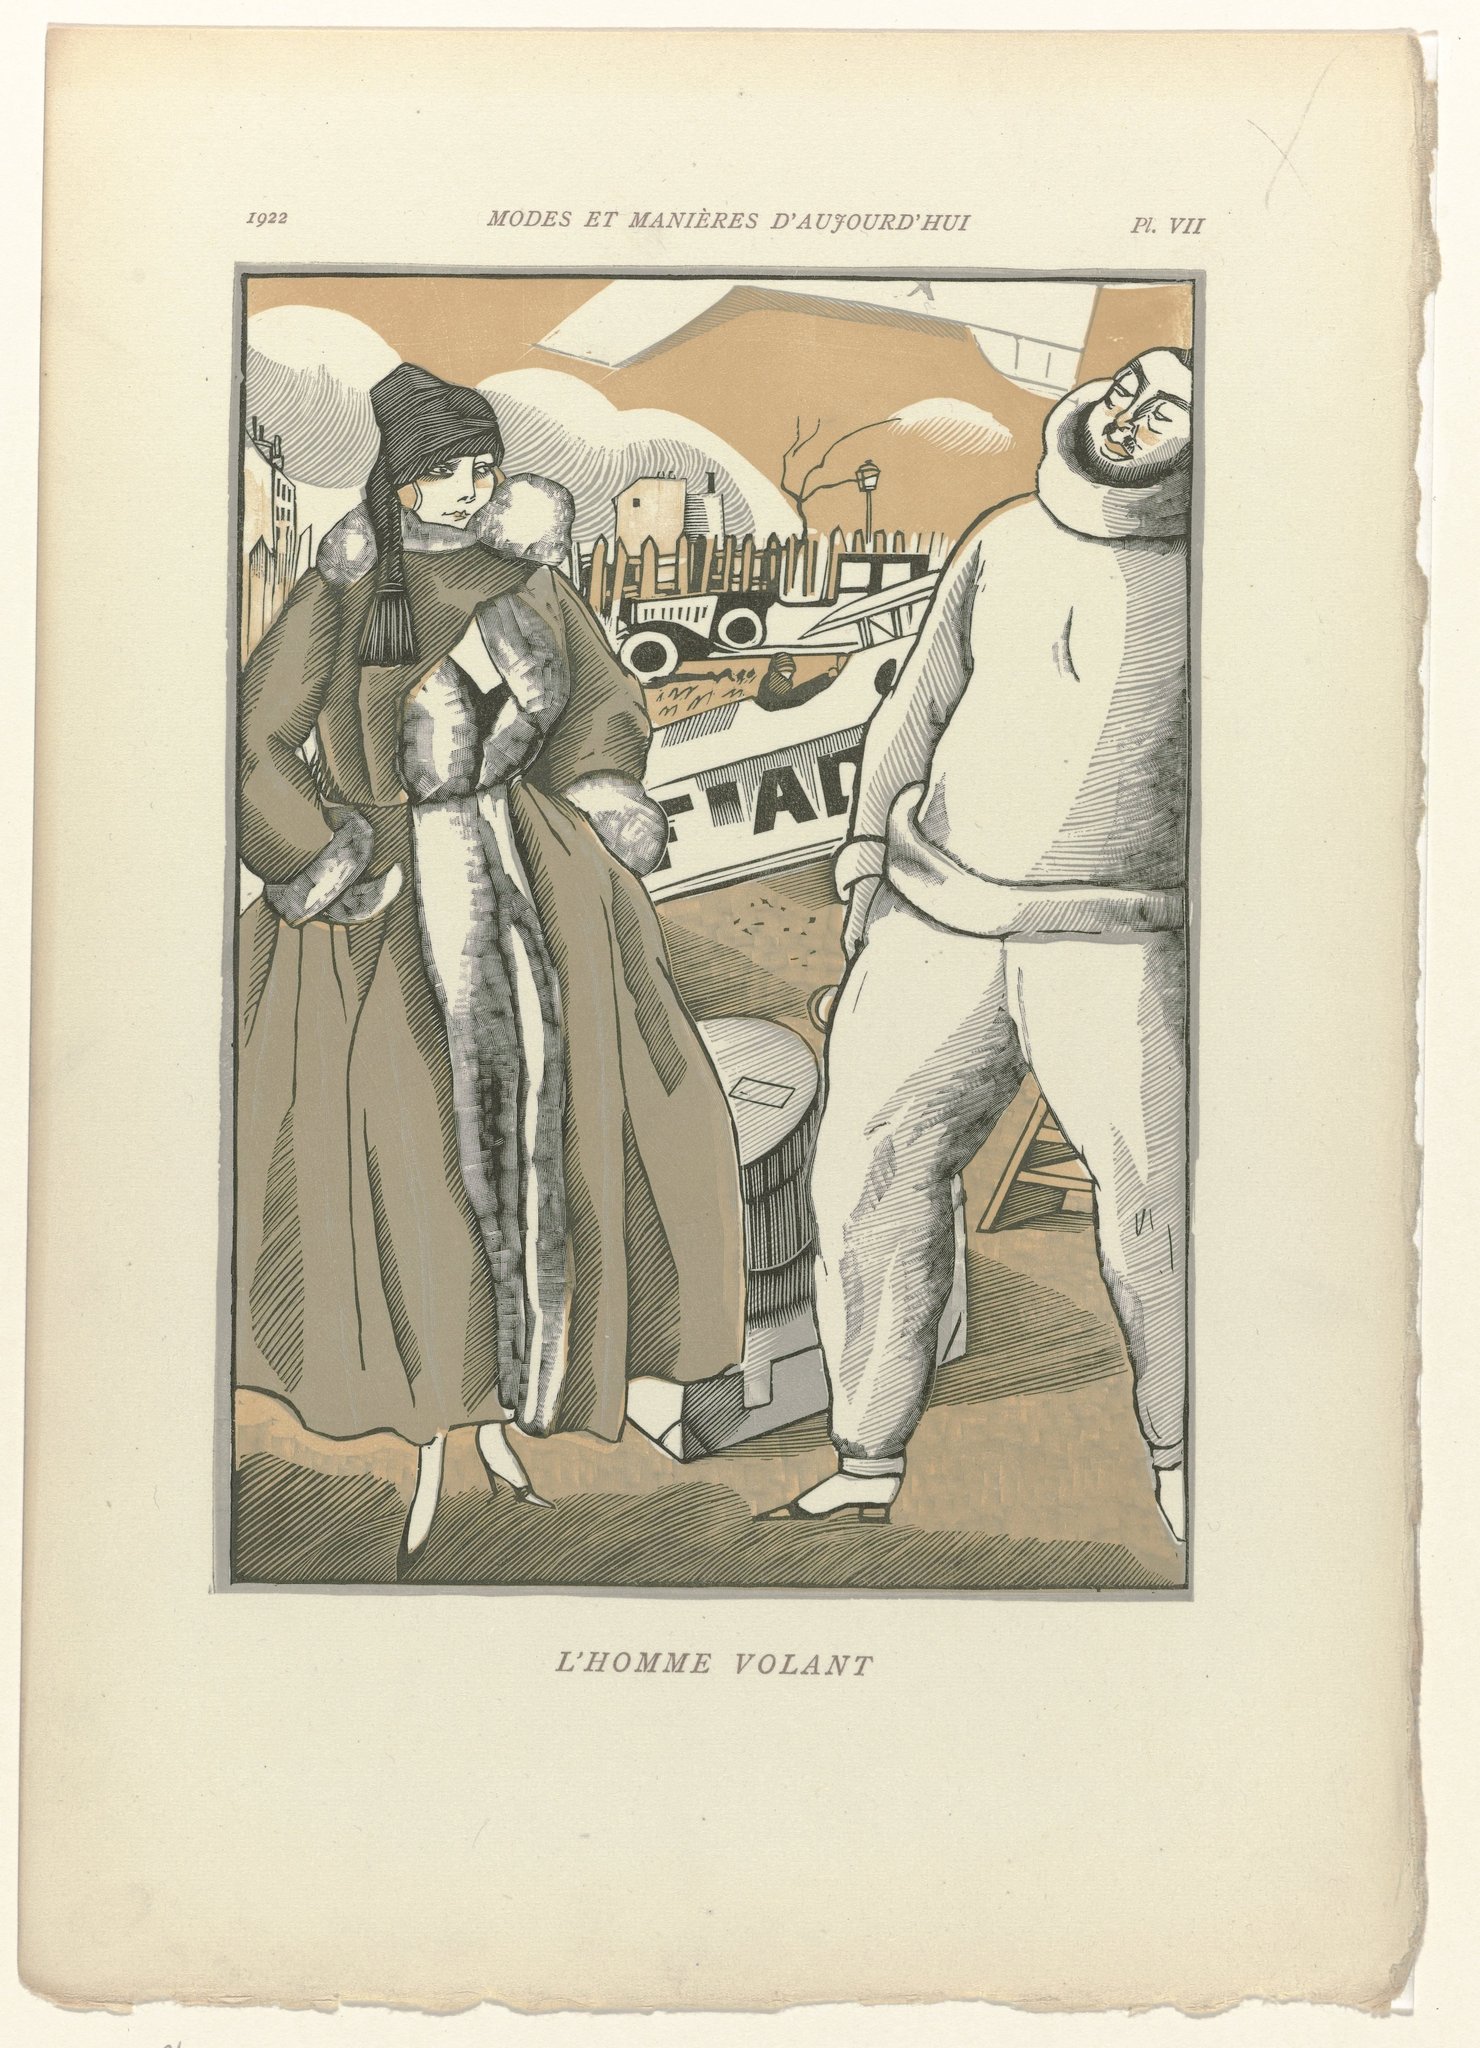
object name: fashion print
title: Modes et Manières d'Aujourd'hui, 1922, Pl. 7 : L'Homme Volant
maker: Anonymous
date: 1922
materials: paper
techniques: pochoir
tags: trousers, breeches, etc. (pantalon) (+ men's clothes), crew and passengers ~ aviation, coat (+ women's clothes), head-gear: cap (+ women's clothes), fashion plates, clothing for the upper part of the body (+ men's clothes), automobile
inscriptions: title: ‘MODES ET MANIÈRES D'AUJOURD'HUI’, caption: ‘L'HOMME VOLANT’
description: Een vrouw in een mantel afgezet met bont staat naast een piloot. Op de grond staan twee koffers. De man draagt een trui en lange broek. Schoen met puntige neus en hak. Op de achtergrond een vliegtuig en auto. De prent maakt deel uit van een serie van 12 houtsneden van Fernand Siméon, met teksten van Paul Valery, voor het zevende deel (10e année 1922) van Modes et Manières d'Aujourd'hui. Elke uitgave had een oplage van slechts 300 stuks en was exclusief gewijd aan één kunstenaar die 12 prenten ontwierp rond een bepaald thema. In deze serie staat het 'leven van de modieuze vrouw in de maatschappij' centraal.